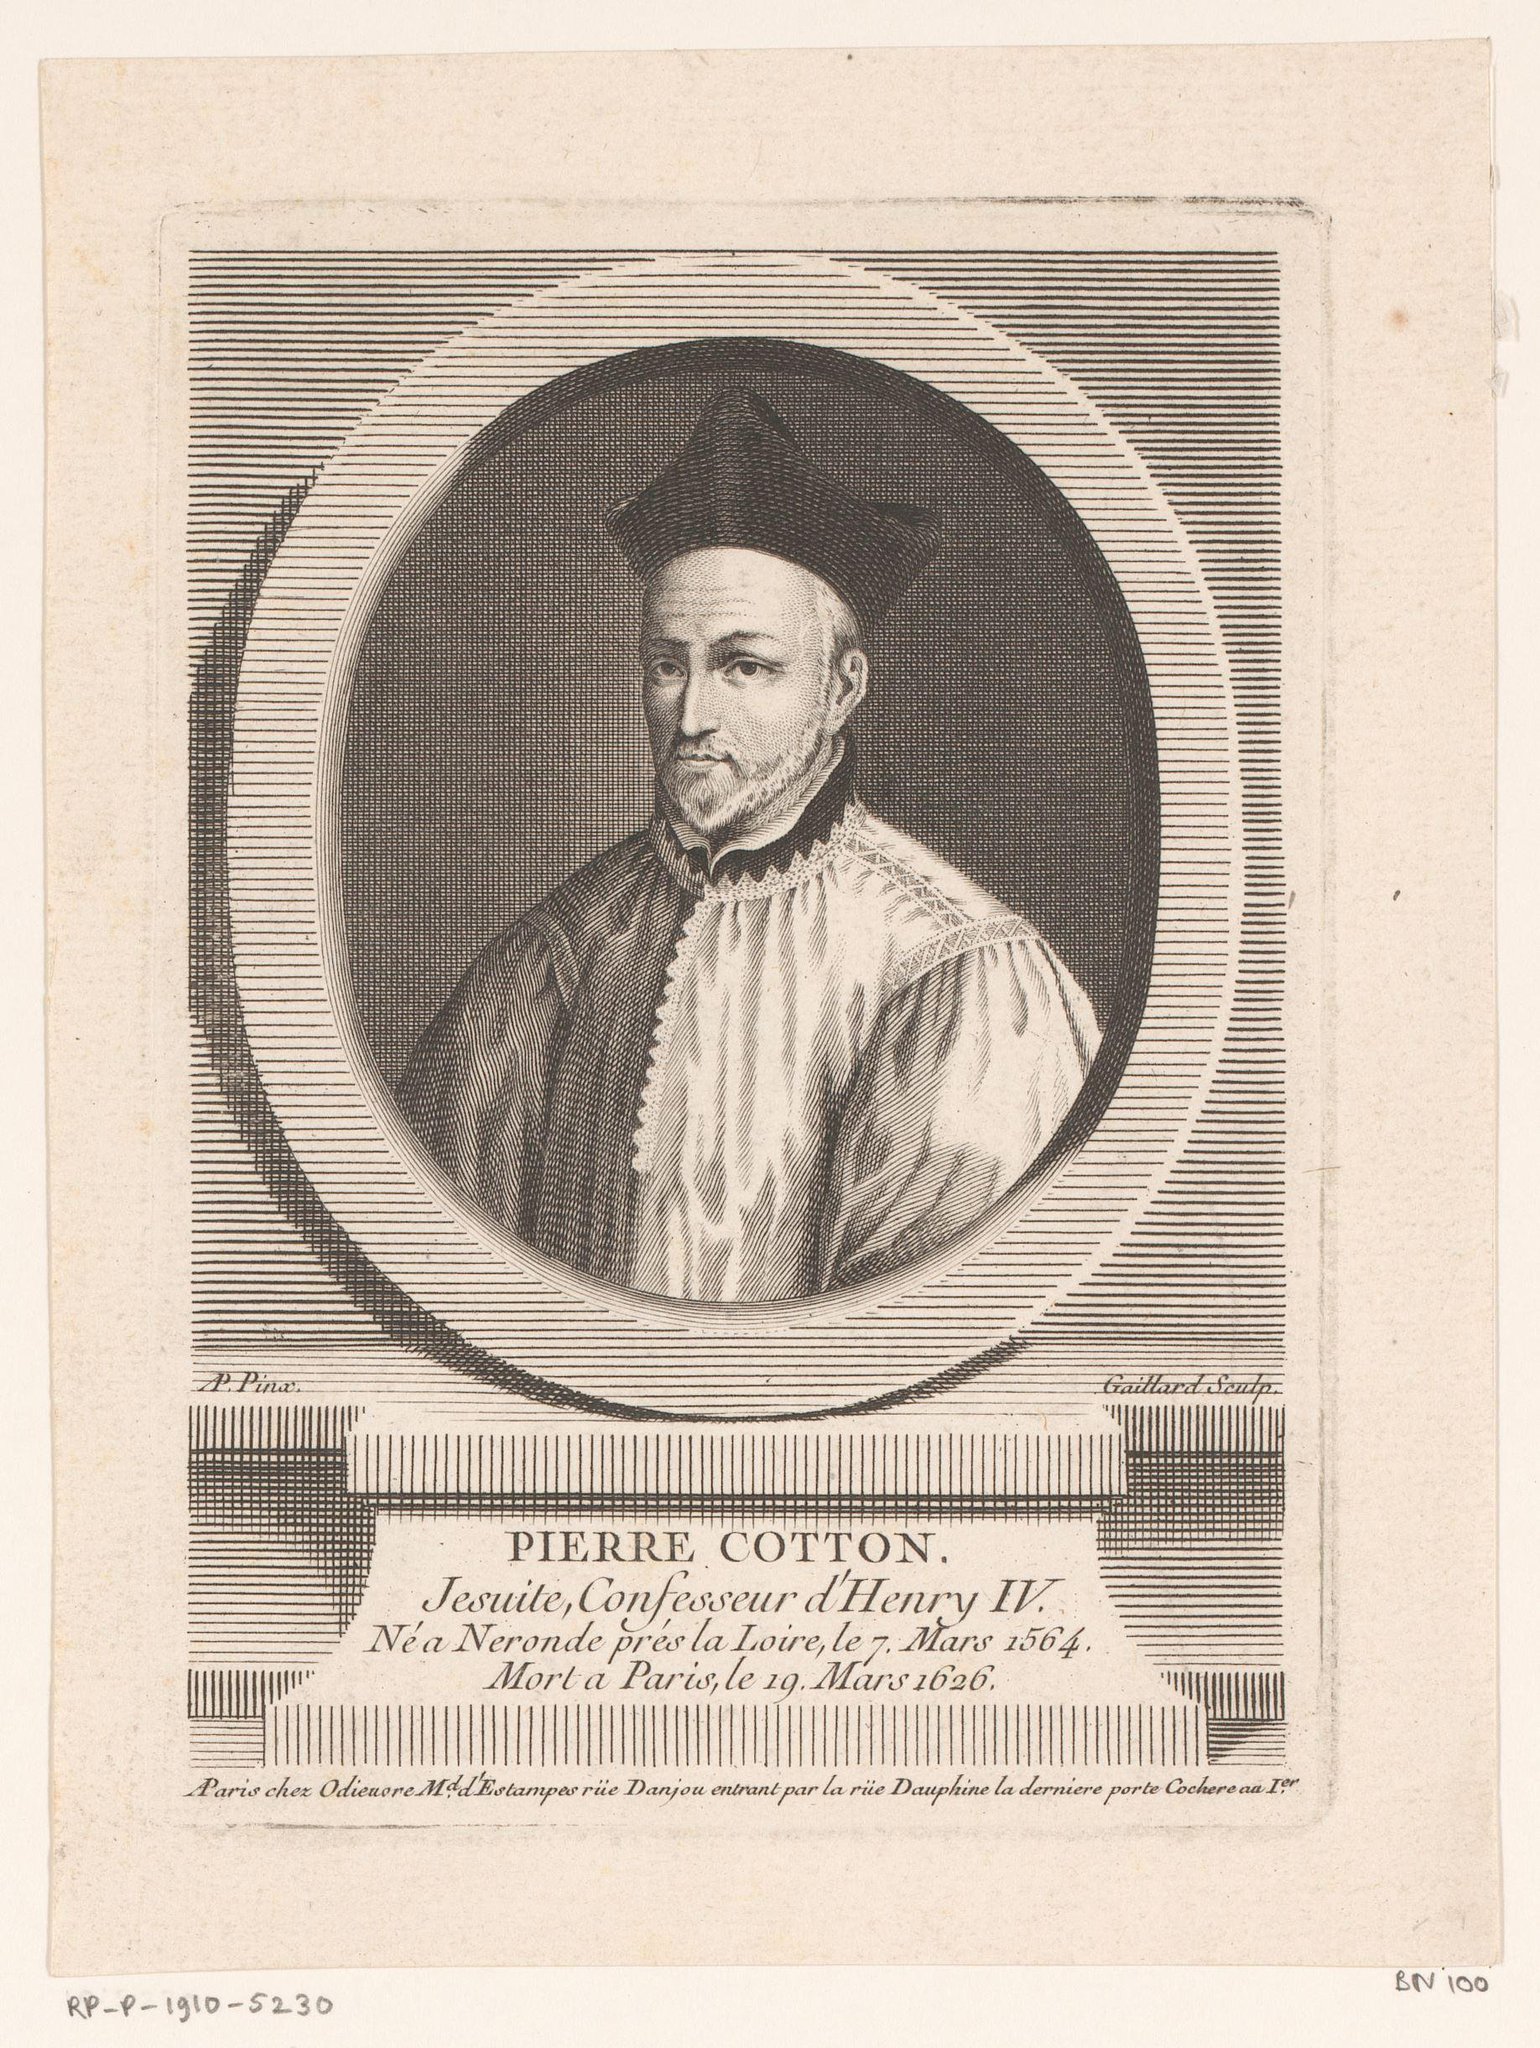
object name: book illustration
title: Portret van Pierre Cotton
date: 1755-1765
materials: paper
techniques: engraving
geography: paris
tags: paris, historical persons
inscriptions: collector's mark: Lugt 2228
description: Mogelijk prent uit: Dreux du Radier, Jean-François. L'Europe illustré, contenant l'histoire abregée des souverains, des princes, des prélats, des ministres, (...) en Europe: dans le XVe. siècle compris, jusqu'à présent. Parijs: Michel Odieuvre en André-François Le Breton, 1755-1765, dl. 3.